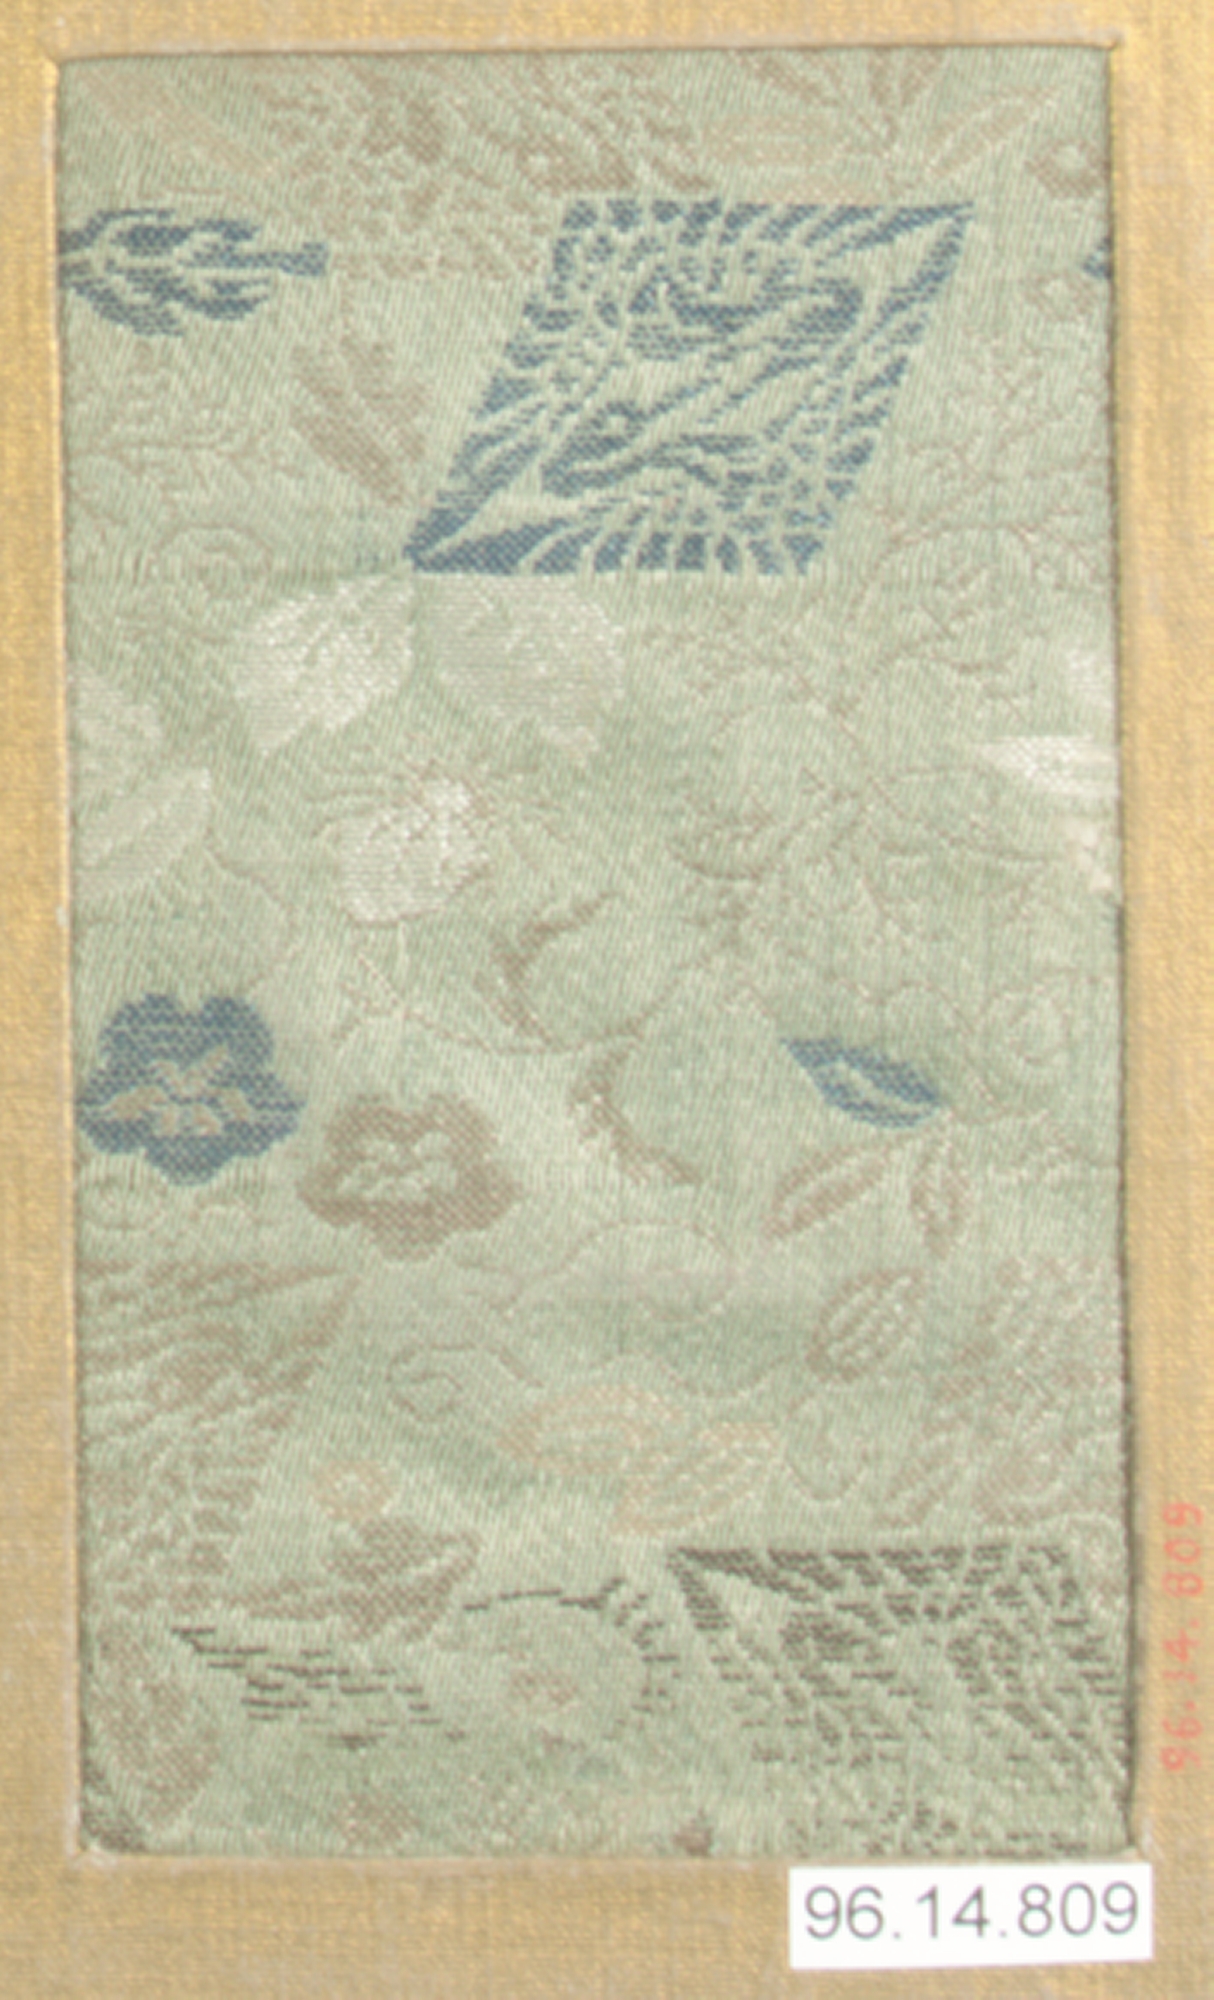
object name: piece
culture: japanese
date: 1701-1900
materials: silk